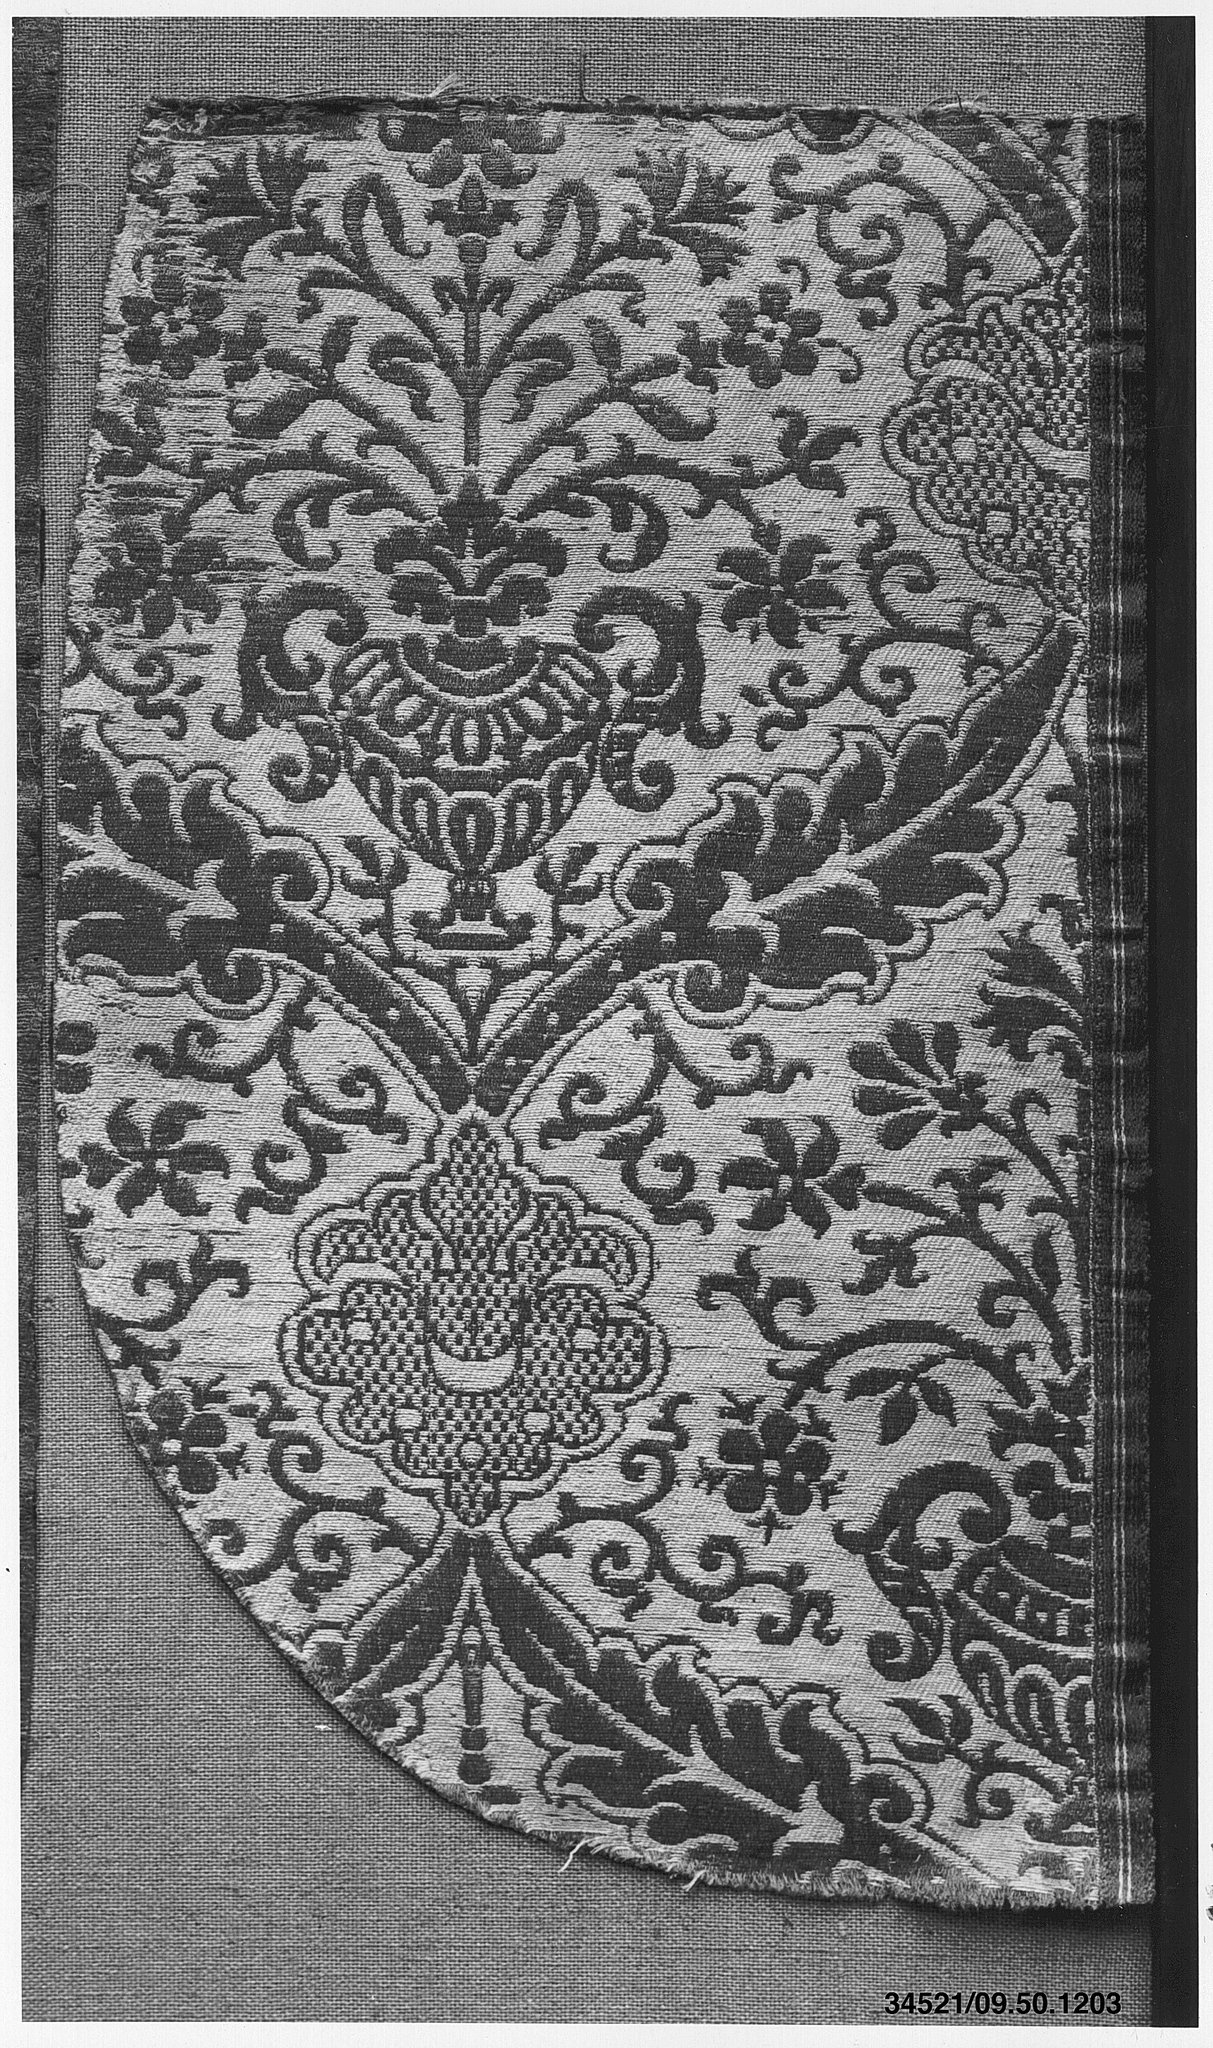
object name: piece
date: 1501-1600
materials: linen, silk